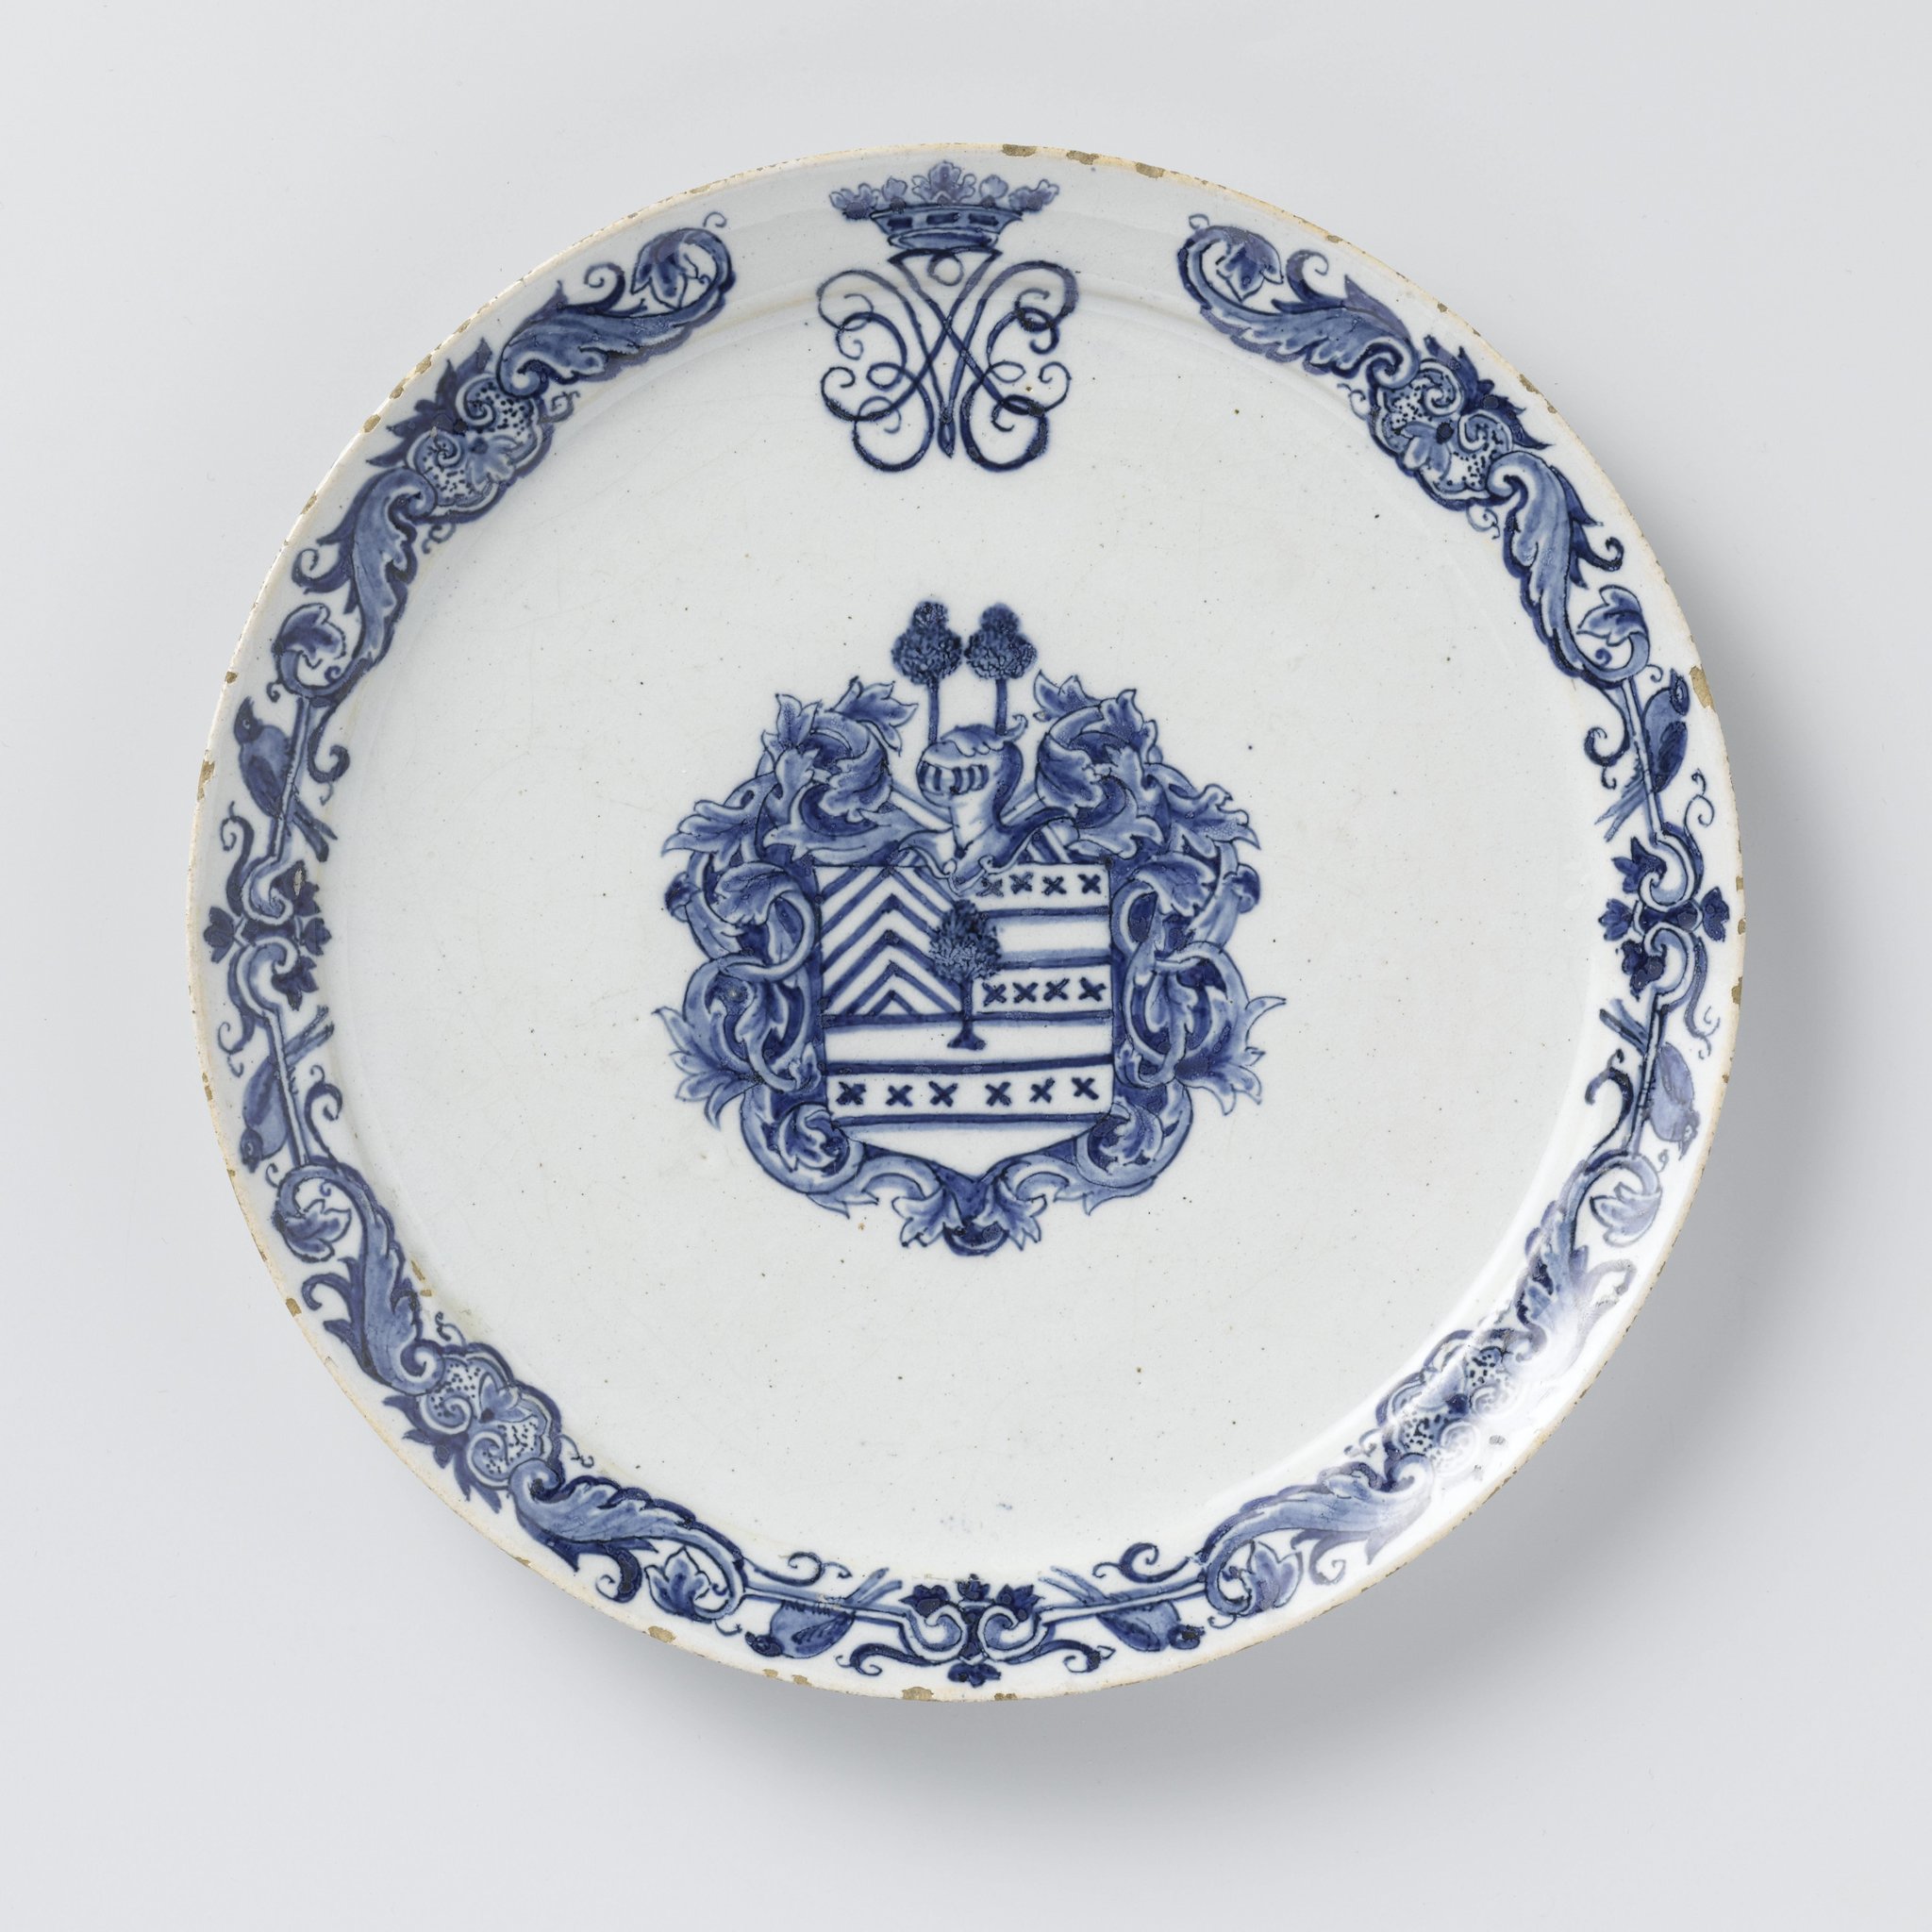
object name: plate dish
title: Bord, beschilderd met een onbekend wapen, mogelijk Van Egmond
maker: Anonymous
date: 1718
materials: faience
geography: delft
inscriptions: date: ‘1718’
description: Bord van aardewerk beschilderd in blauw op tinglazuur met in het plat een onbekend wapen, mogelijk van een lid van een onbekend geslacht Van Egmond. Daarboven een gekroond spiegelmonogram J.V.E. De rand gedecoreerd met bladwerk.